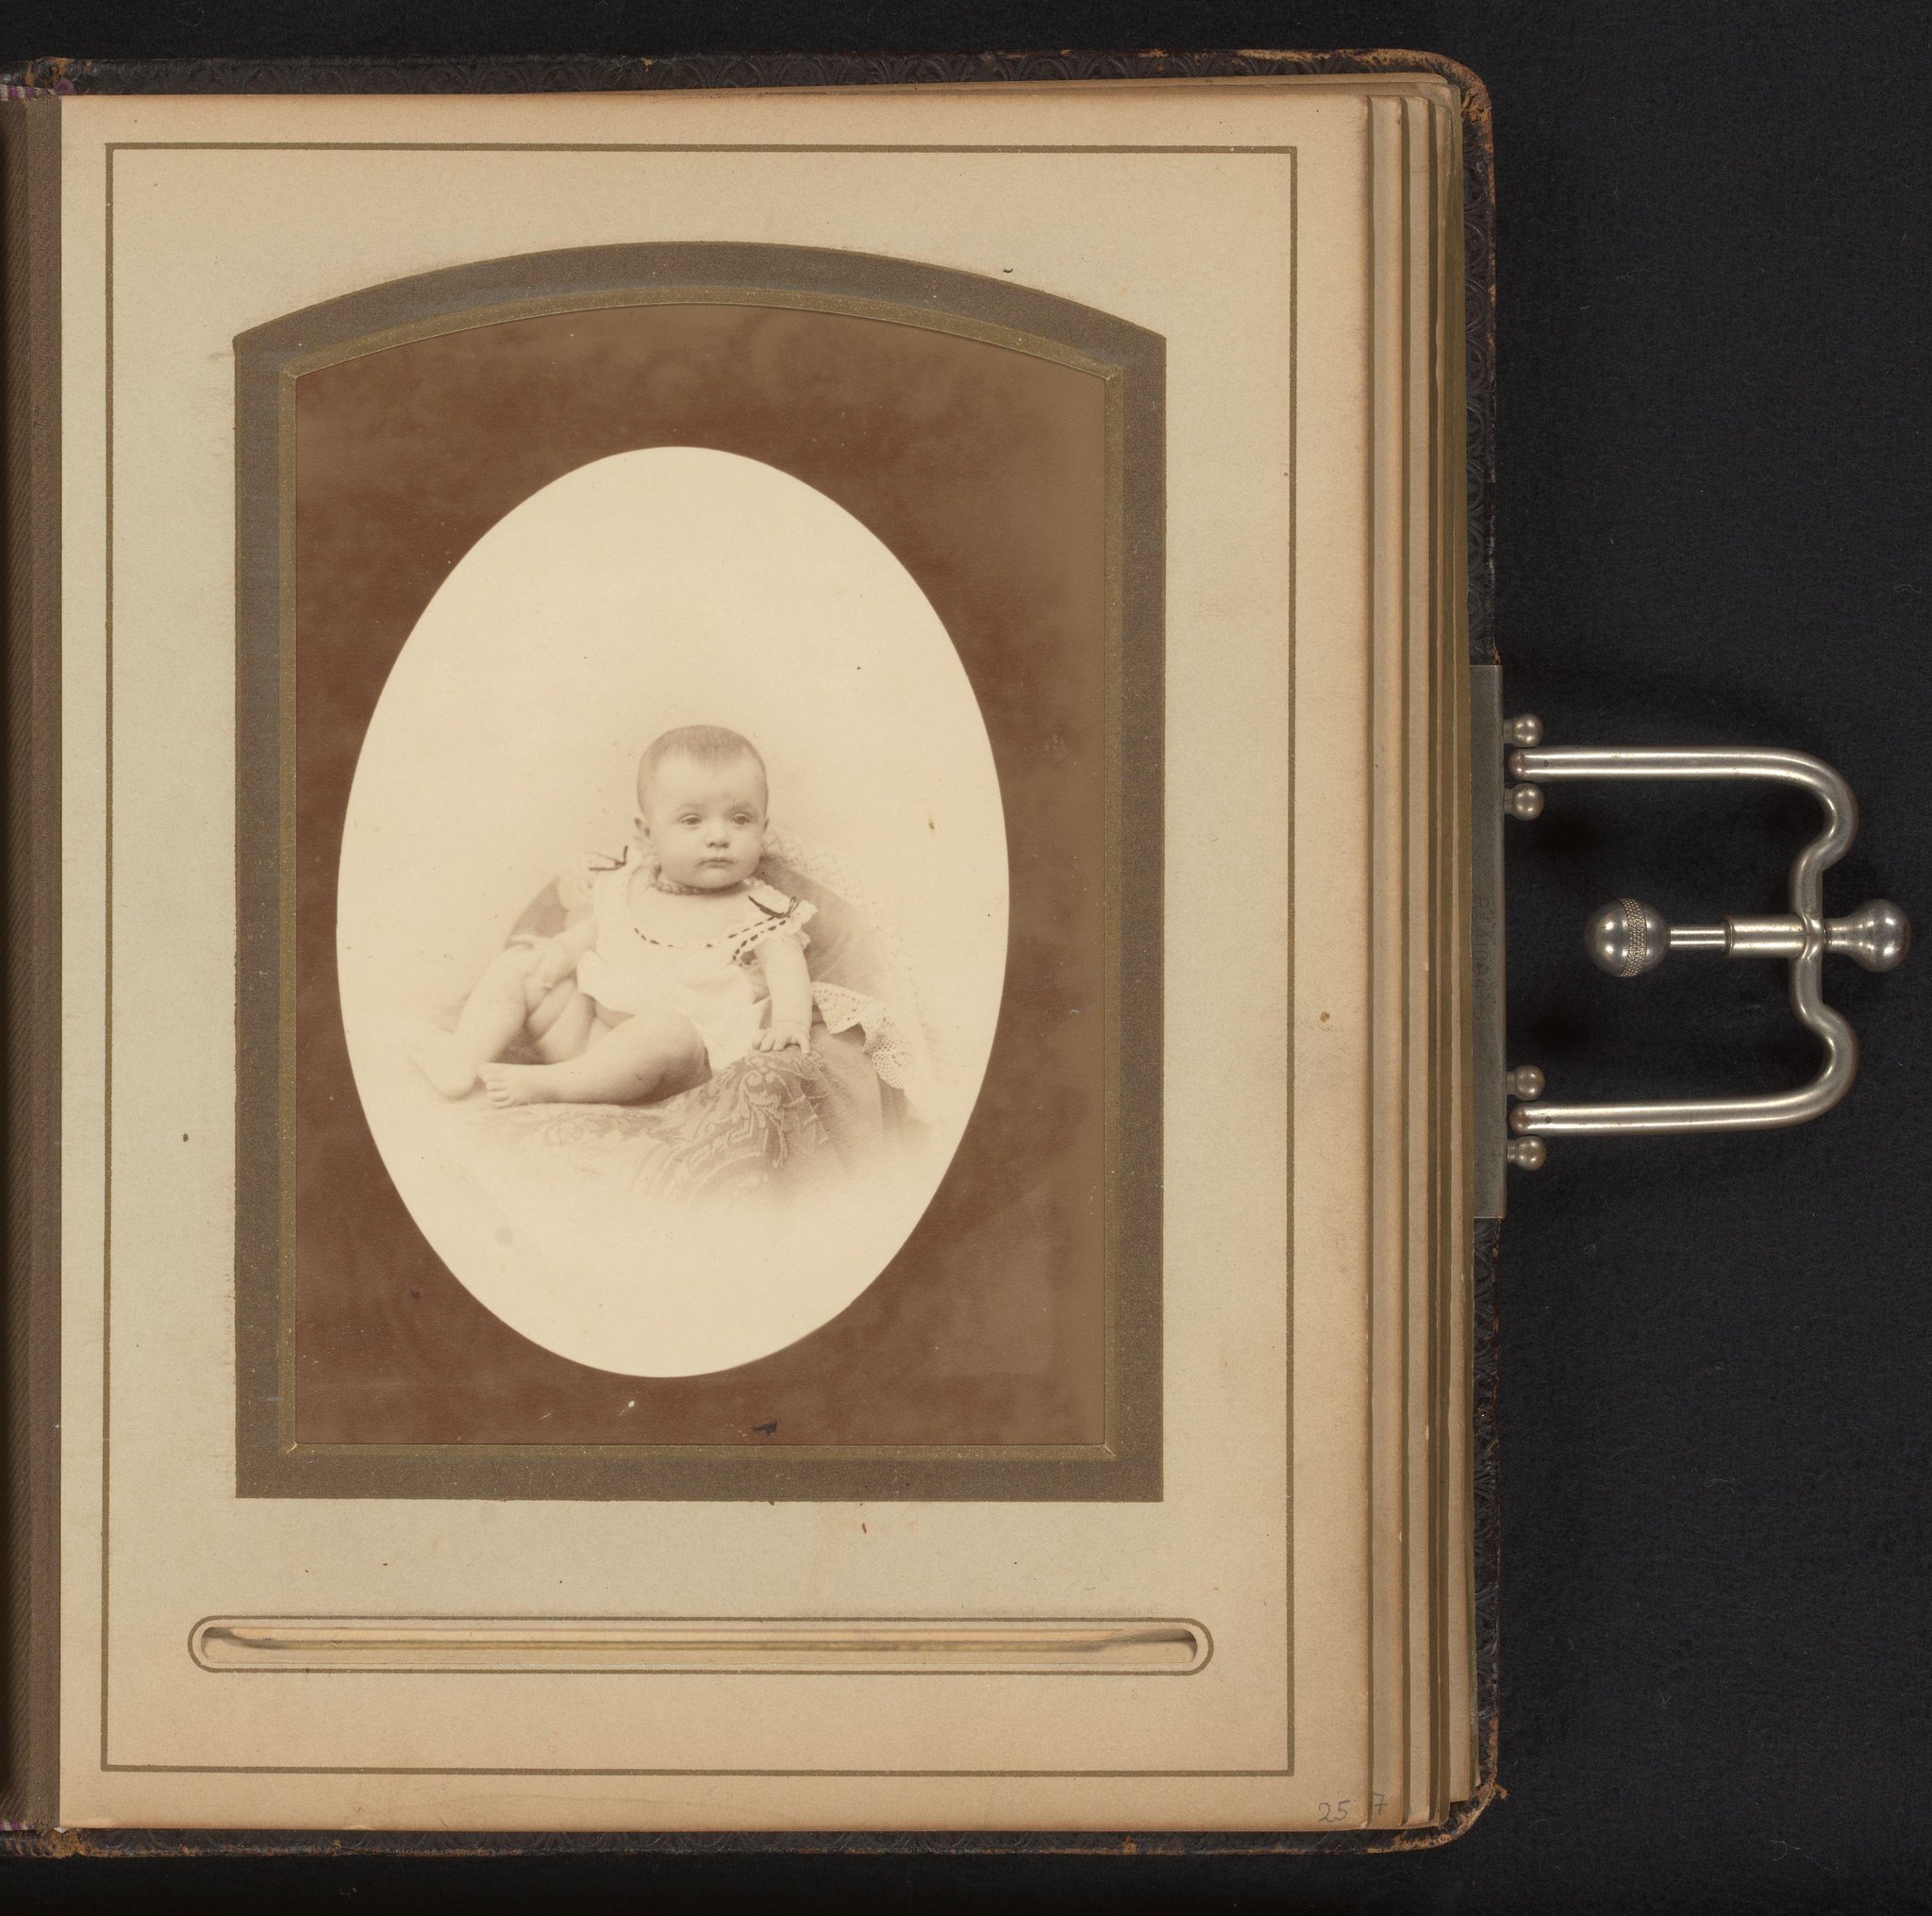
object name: photograph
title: Portret van een zittende baby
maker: berger (fotograaf)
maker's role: fotograaf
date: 1850-1900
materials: cardboard, photographic support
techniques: albumen print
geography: paris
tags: sitting figure, historical persons, infant, baby ~ the ages of man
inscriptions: inscription: ‘Berger/ Photographie/ des Champs-Elysées/ Ci-devant:/ 28, Avenue des Champs-Elysées/ TRANSFÉRÉE/ 112, Rue de Courcelles/ LEVALLOIS/ Hôtel Privé’